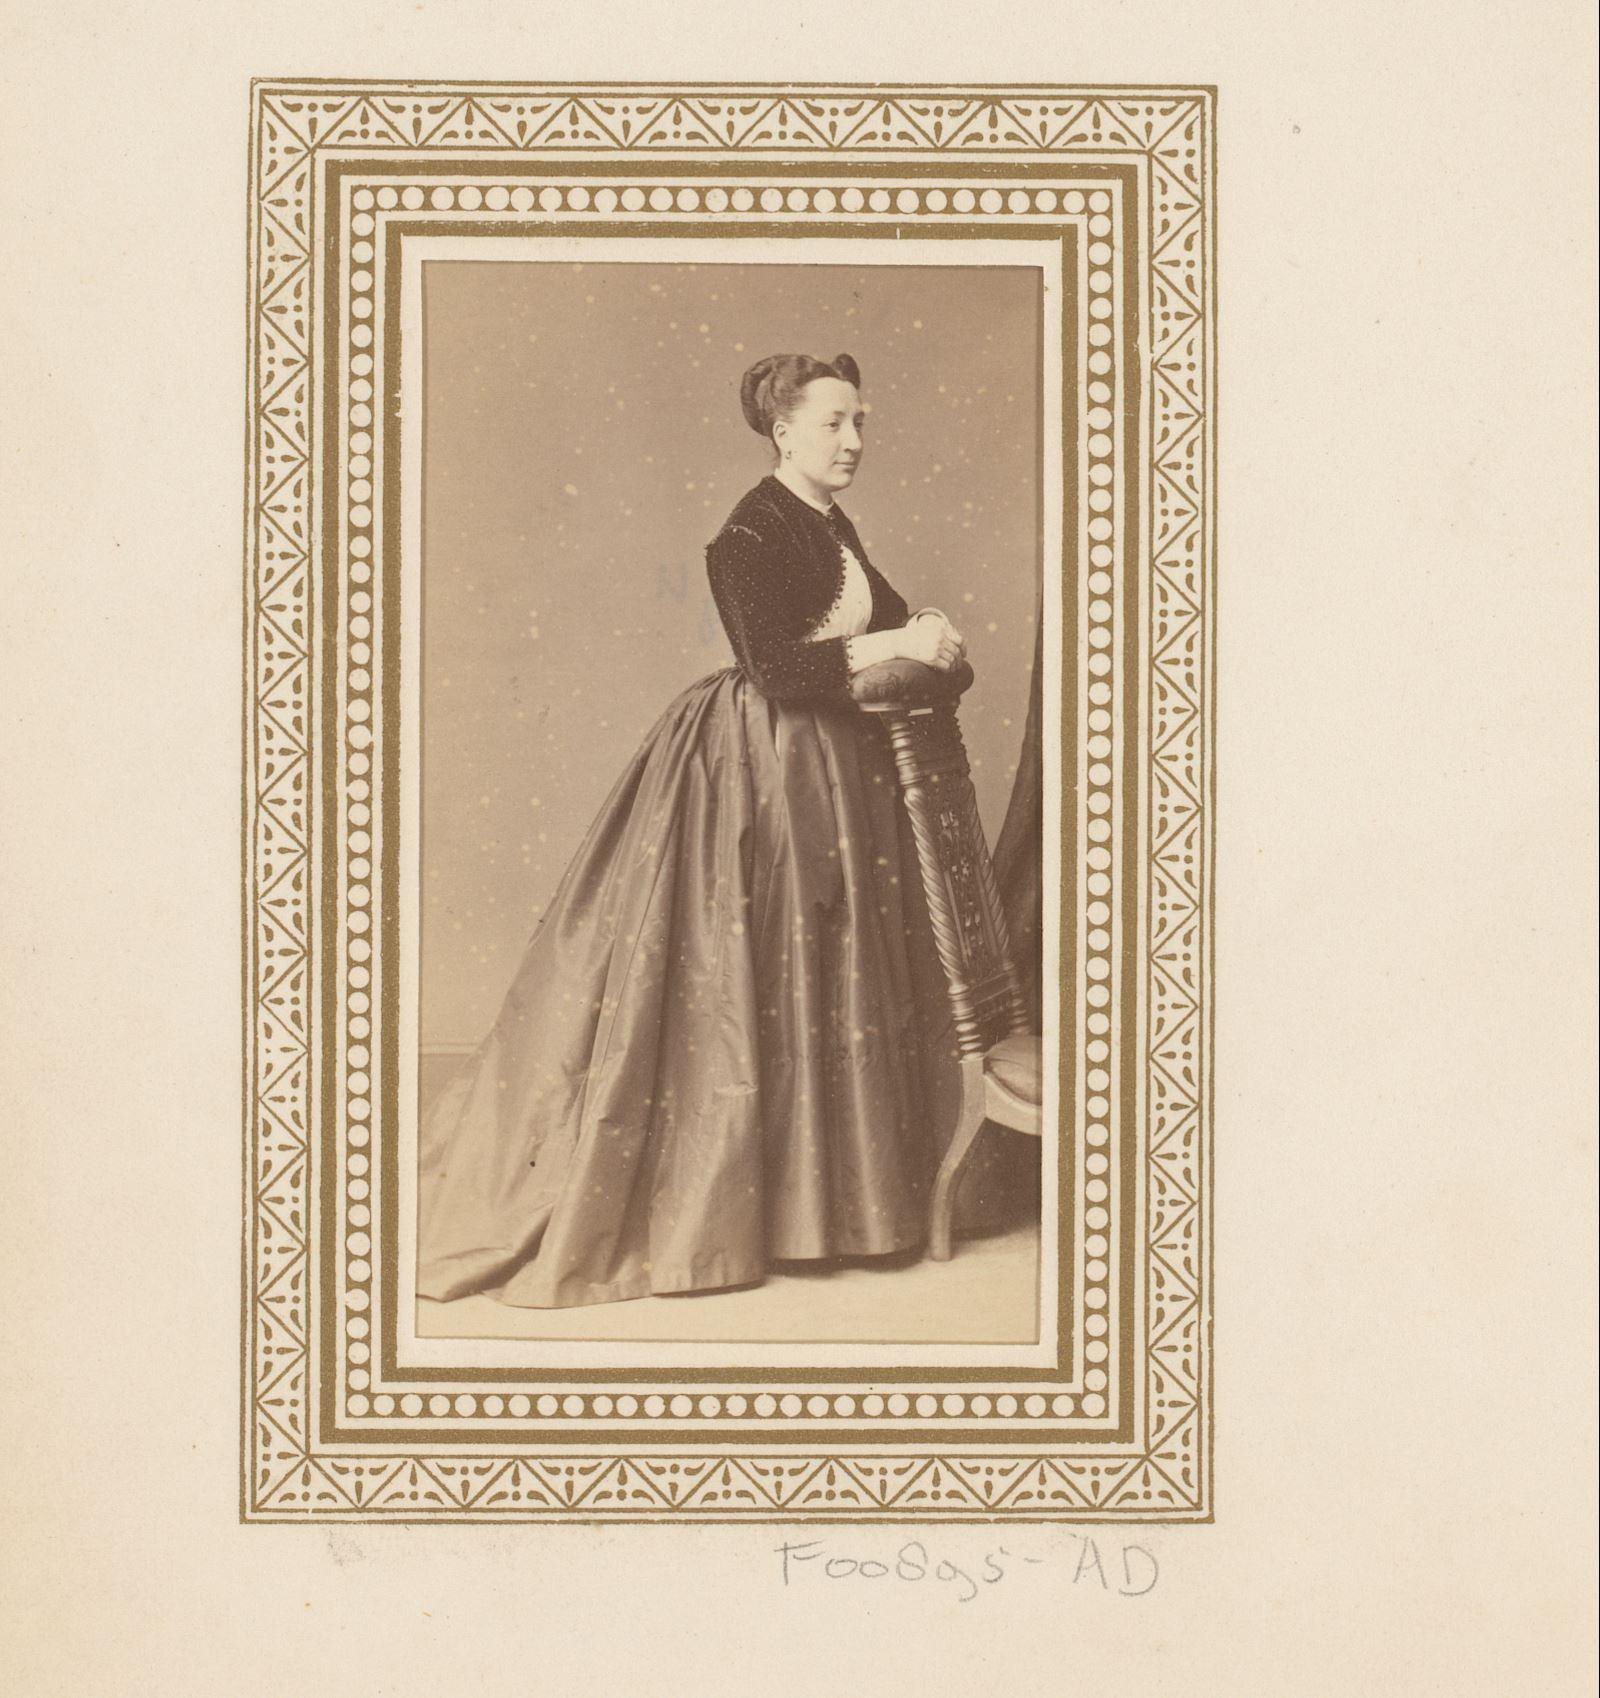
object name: photograph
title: Portret van een staande vrouw bij een stoel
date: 1855-1890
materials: cardboard, photographic support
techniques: albumen print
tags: historical persons, standing figure - aa - female human figure, chair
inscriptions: inscription: ‘Honorable Mention/ Turner & Co./ 17. Upper Street./ Islington, N.’, number: ‘24884’